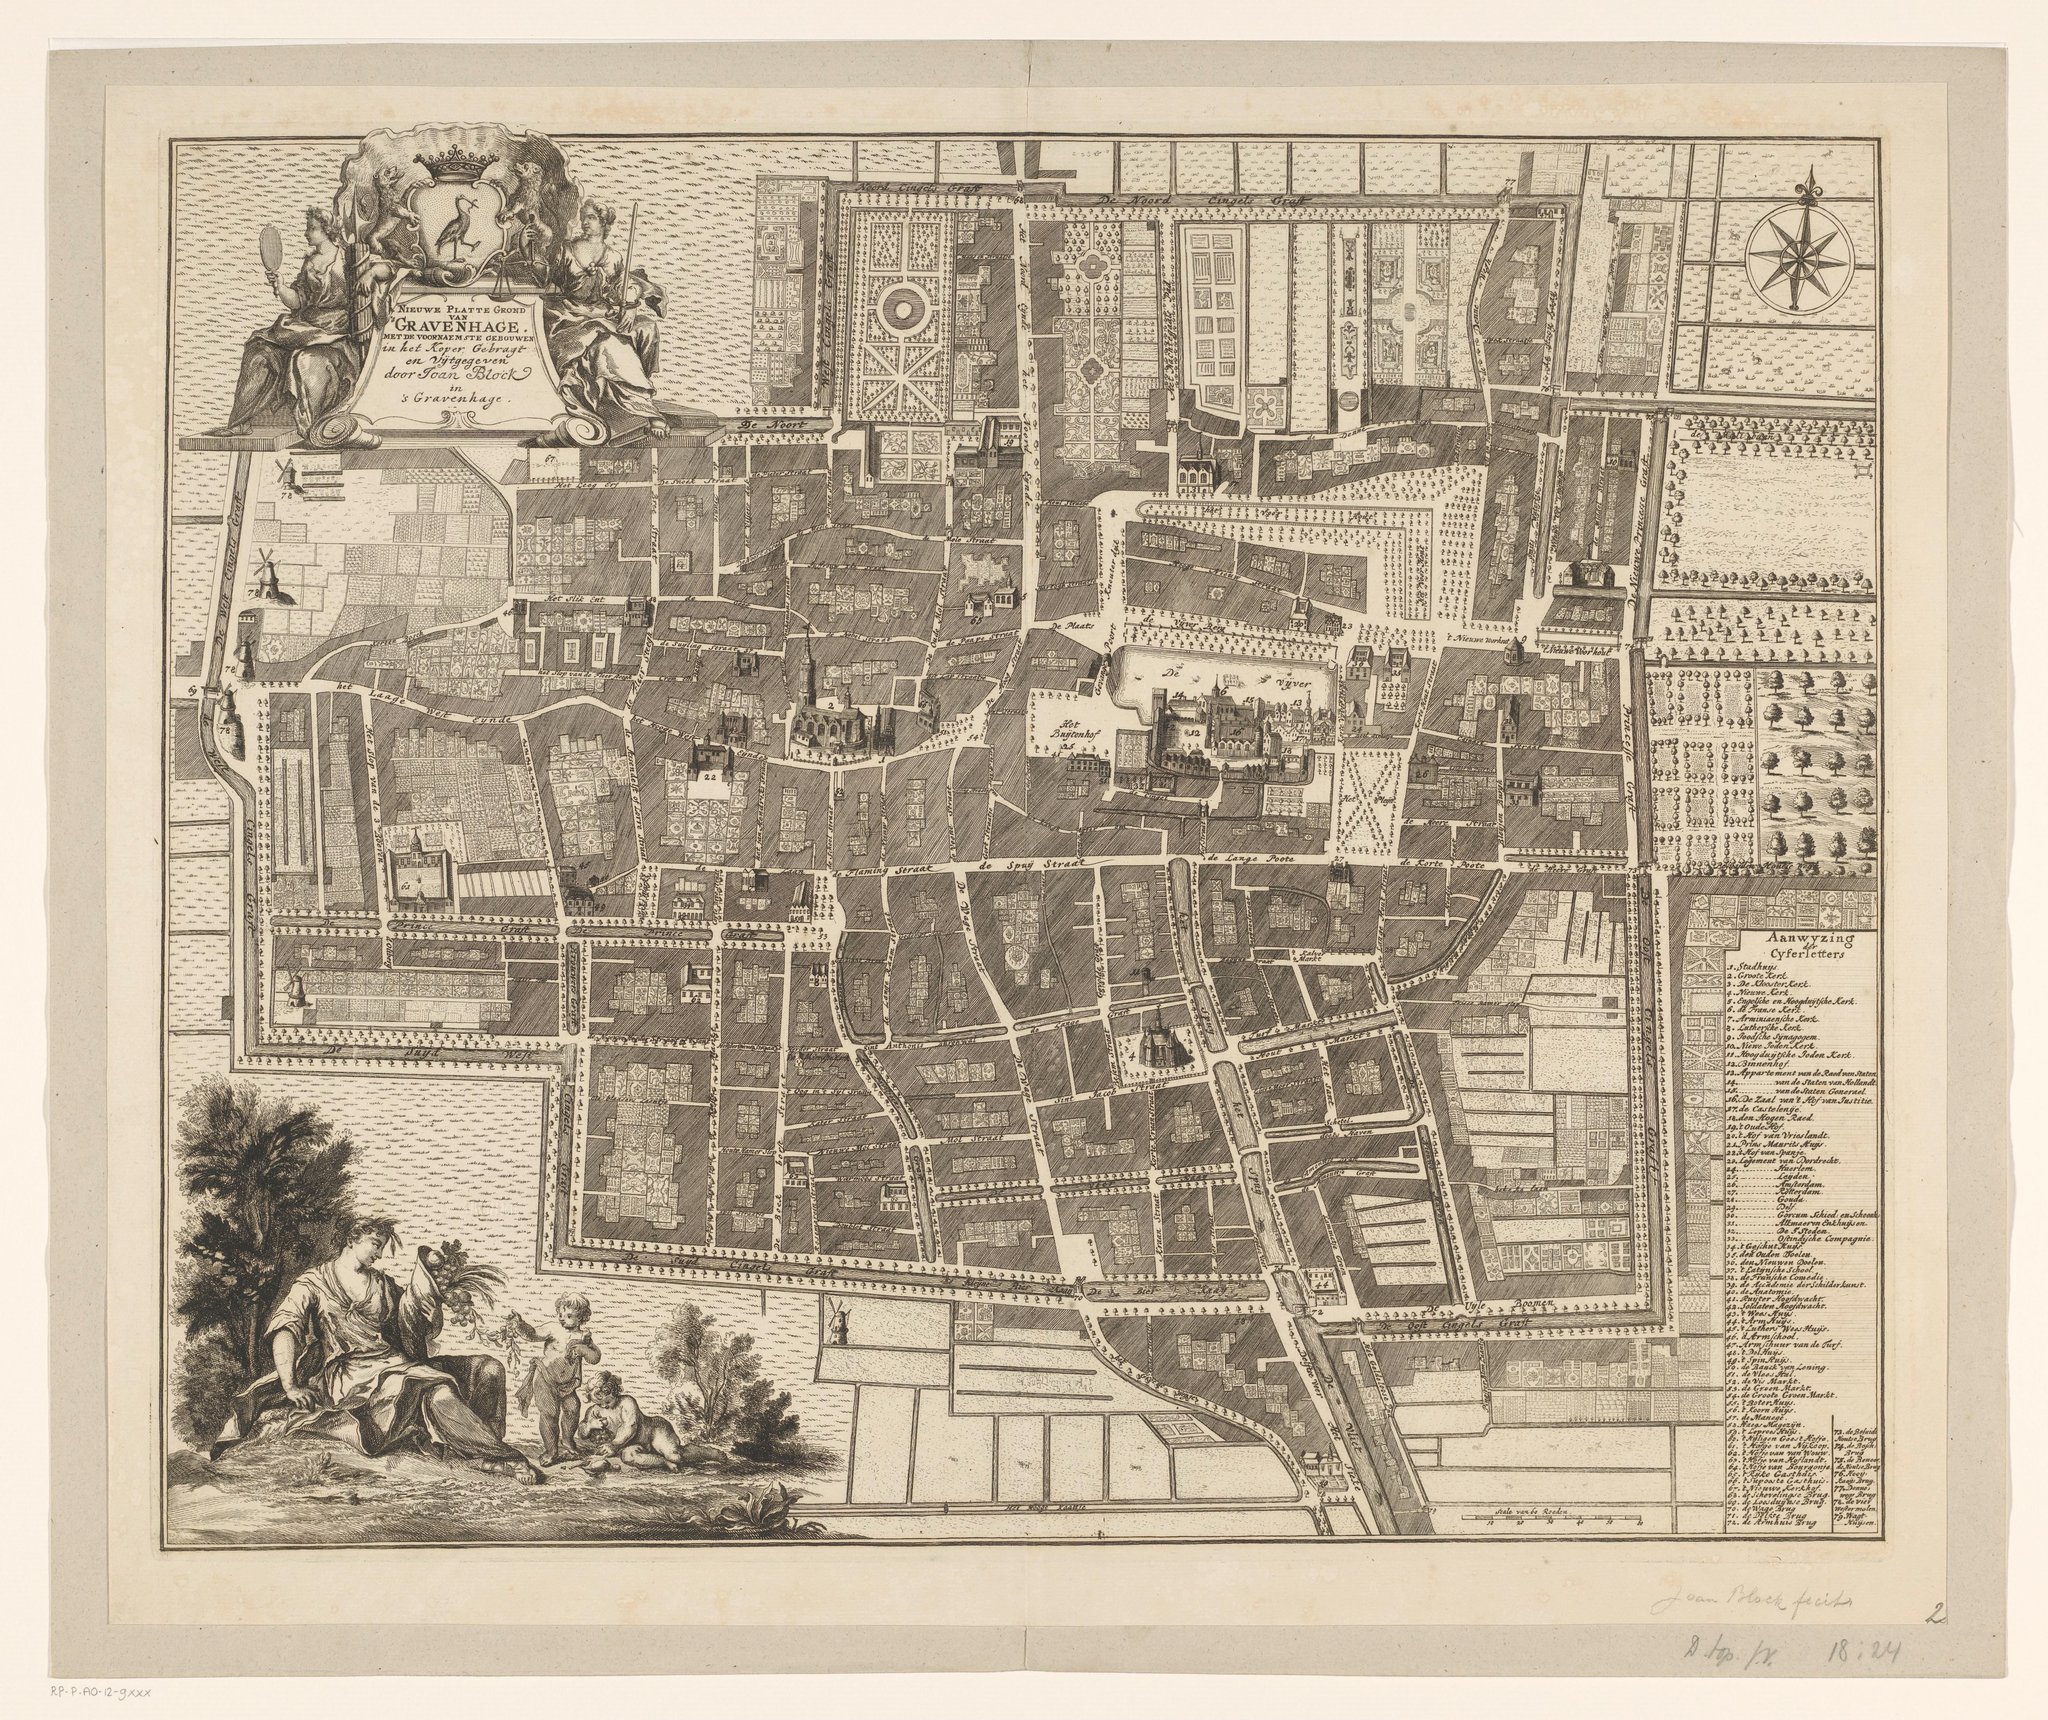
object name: area plan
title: Nieuwe platte grond van 's Gravenhage. Met de voornaemste gebouwen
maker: joan block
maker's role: print maker, publisher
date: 1736-1742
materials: paper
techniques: engraving, etching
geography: the hague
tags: coat of arms (as symbol of the state, etc.) (+ city; municipal), 'cornucopia', horn of plenty, justitia (justice) as roman personification, maps of cities, symbols and allegories of jurisprudence (+ 'fasces cum securibus'), the hague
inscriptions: collector's mark: Lugt 2228, check stamp: ‘Archief Ministerie van Oorlog Afdeeling Genie’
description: Plattegrond met gebouwen in vogelvluchtperspectief. Linksboven de titelcartouche met boven het wapen van Den Haag, links een vrouwfiguur met een spiegel en een fasces (mogelijk een verpersoonlijking van rechtvaardigheid) en rechts Justitia. Linksonder een vrouwfiguur met de hoorn des overvloeds en twee jongetjes. Rechtsonder een legenda 1-79. Links daarvan een schaalstok: Scale van 60 roeden.